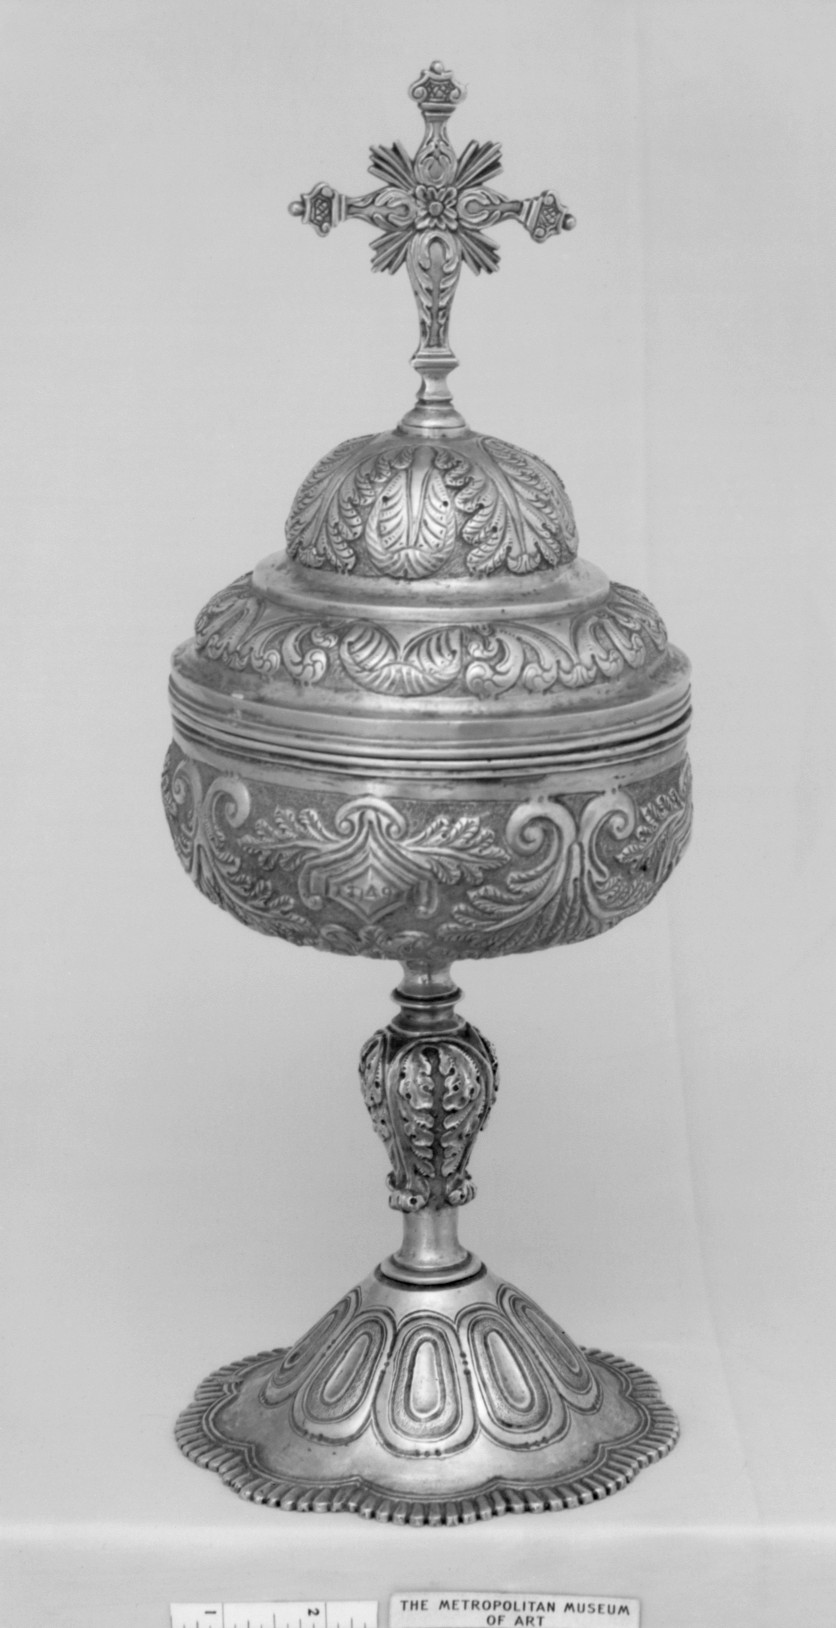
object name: ciborium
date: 1701-1800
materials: silver gilt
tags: cross